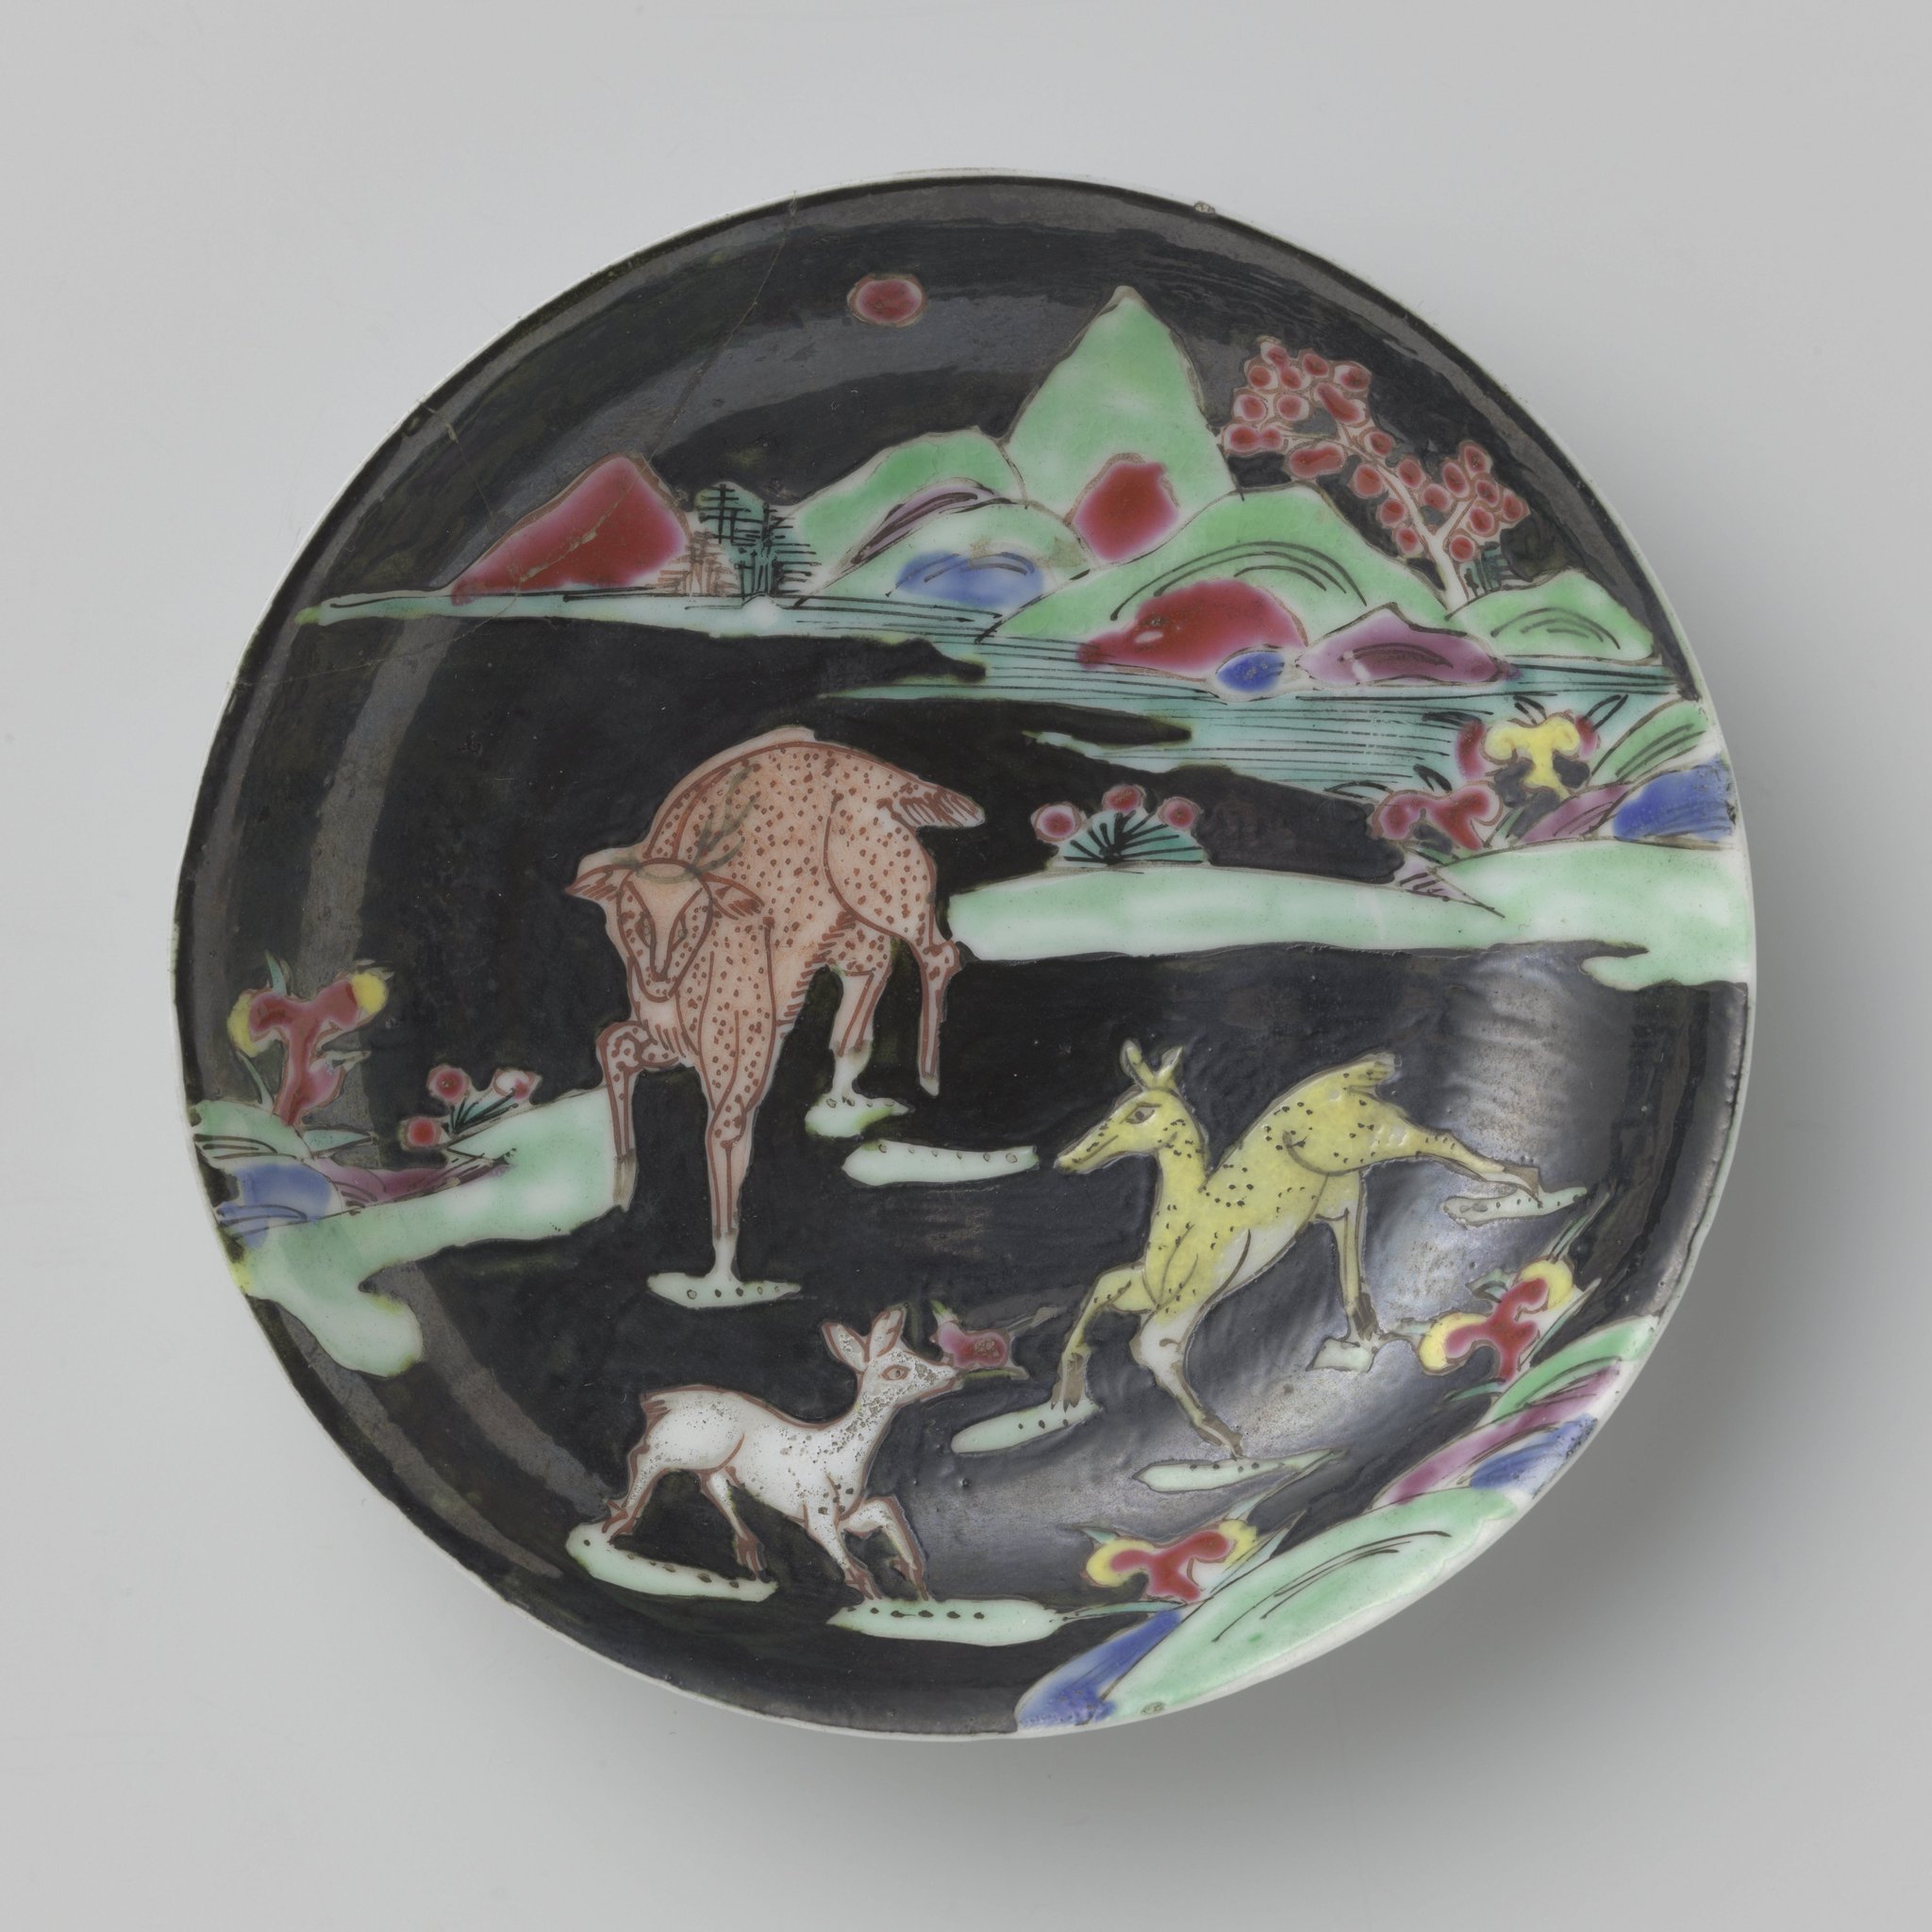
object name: platter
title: Saucer with deer in a water landscape on a black ground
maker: Anonymous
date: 1700-1724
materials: glaze, paint, porcelain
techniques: firing, turning, vitrification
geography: china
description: Schotel van porselein, beschilderd op biscuit in blauw, rood, roze, groen, geel en zwart. Het plat van de schotel is bedekt met een zwart glazuur met hierin uitgespaard drie herten in een rivierlandschap met bomen, bergen en paddestoelen (lingzhi). Wand van de schotel is gebroken geweest. Mogelijk in Europa gedecoreerd. Famille noire met famille rose kleuren.